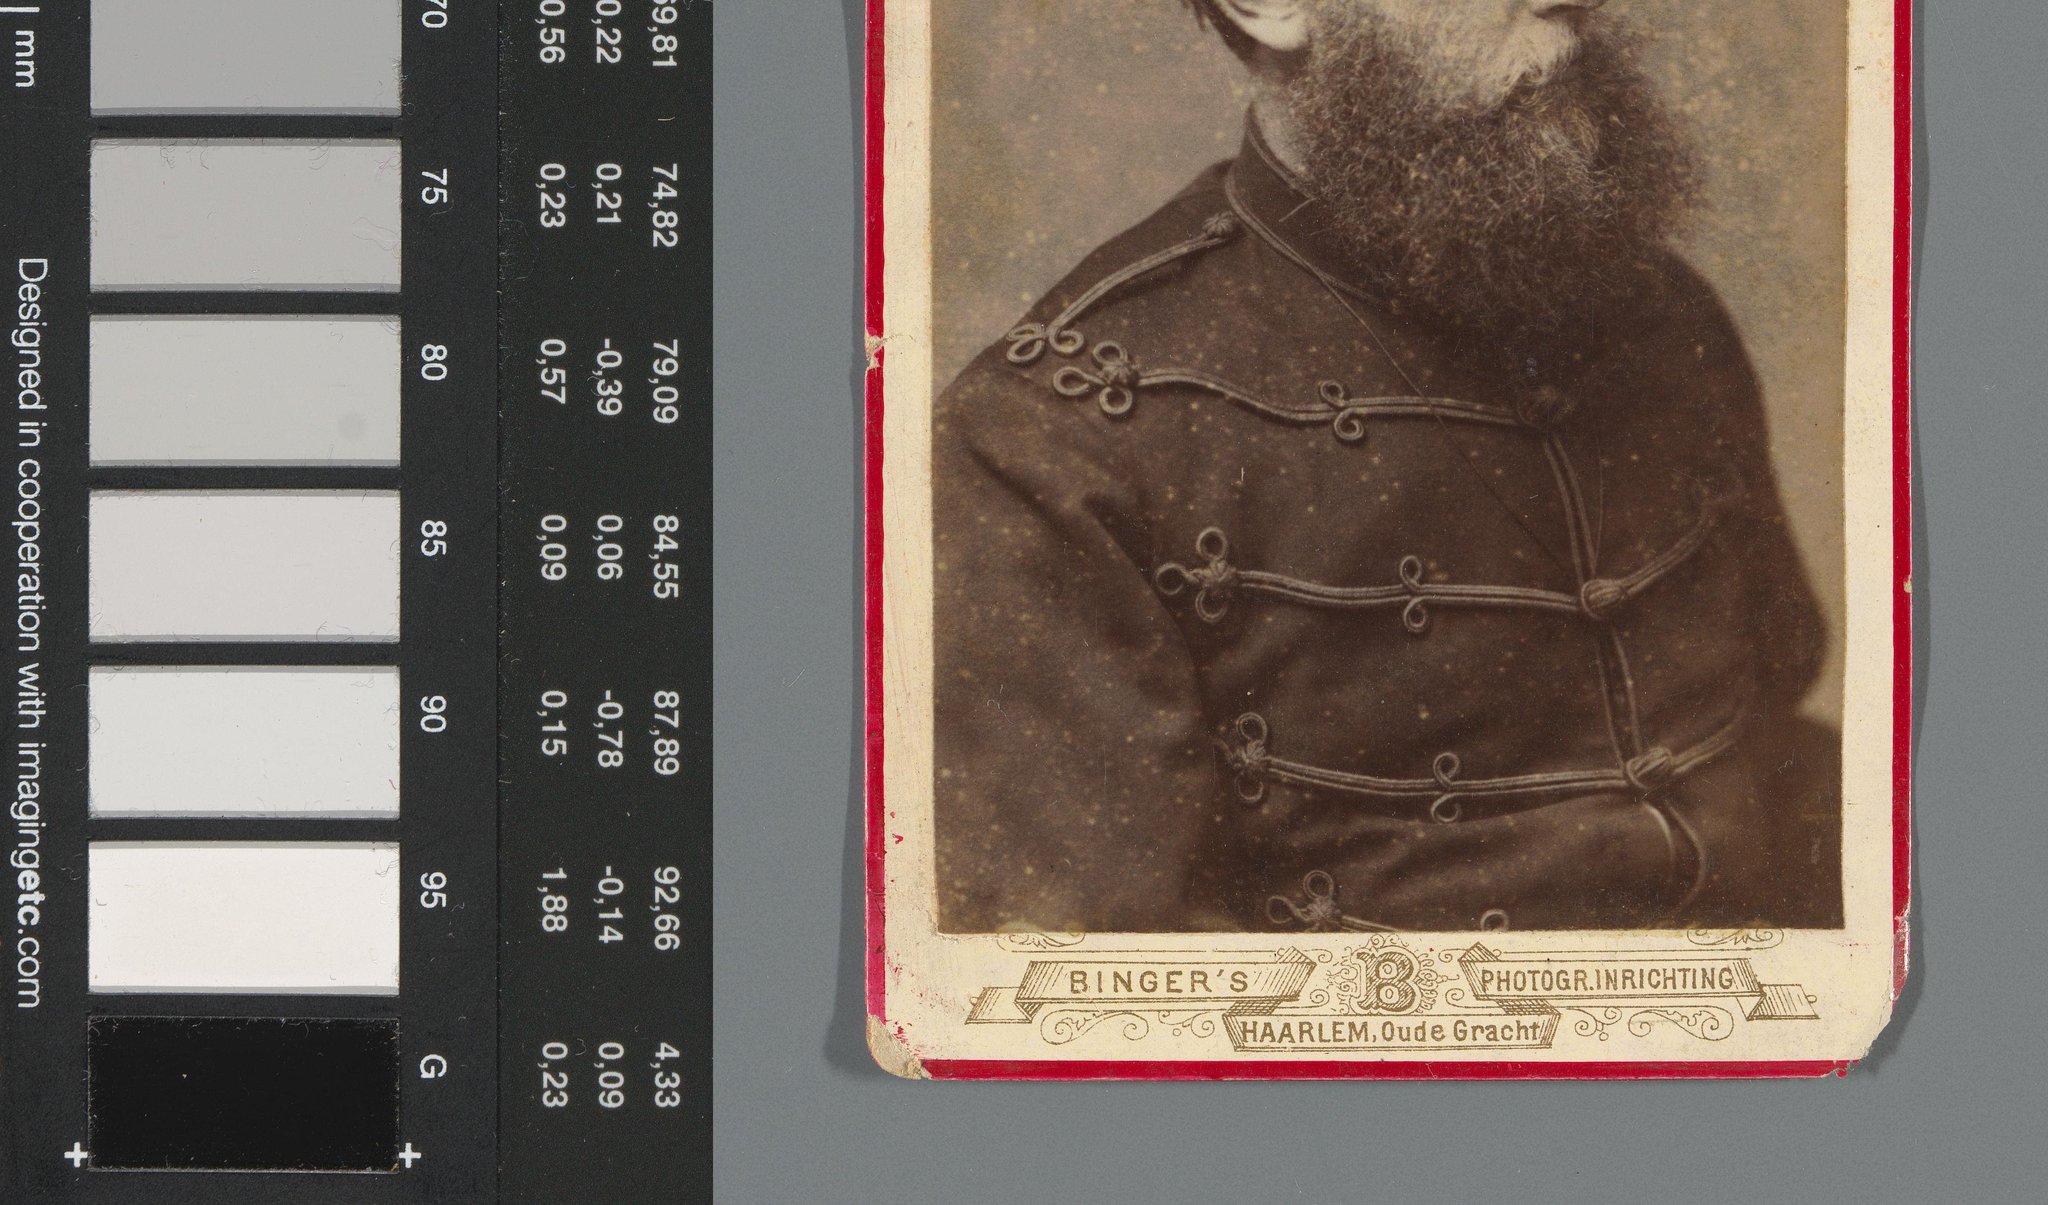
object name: photograph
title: Portret van Francis Marius Baron van Lynden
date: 1865-1895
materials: cardboard, photographic support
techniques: photography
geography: haarlem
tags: historical persons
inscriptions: annotation: ‘FM Baron v Lynden’